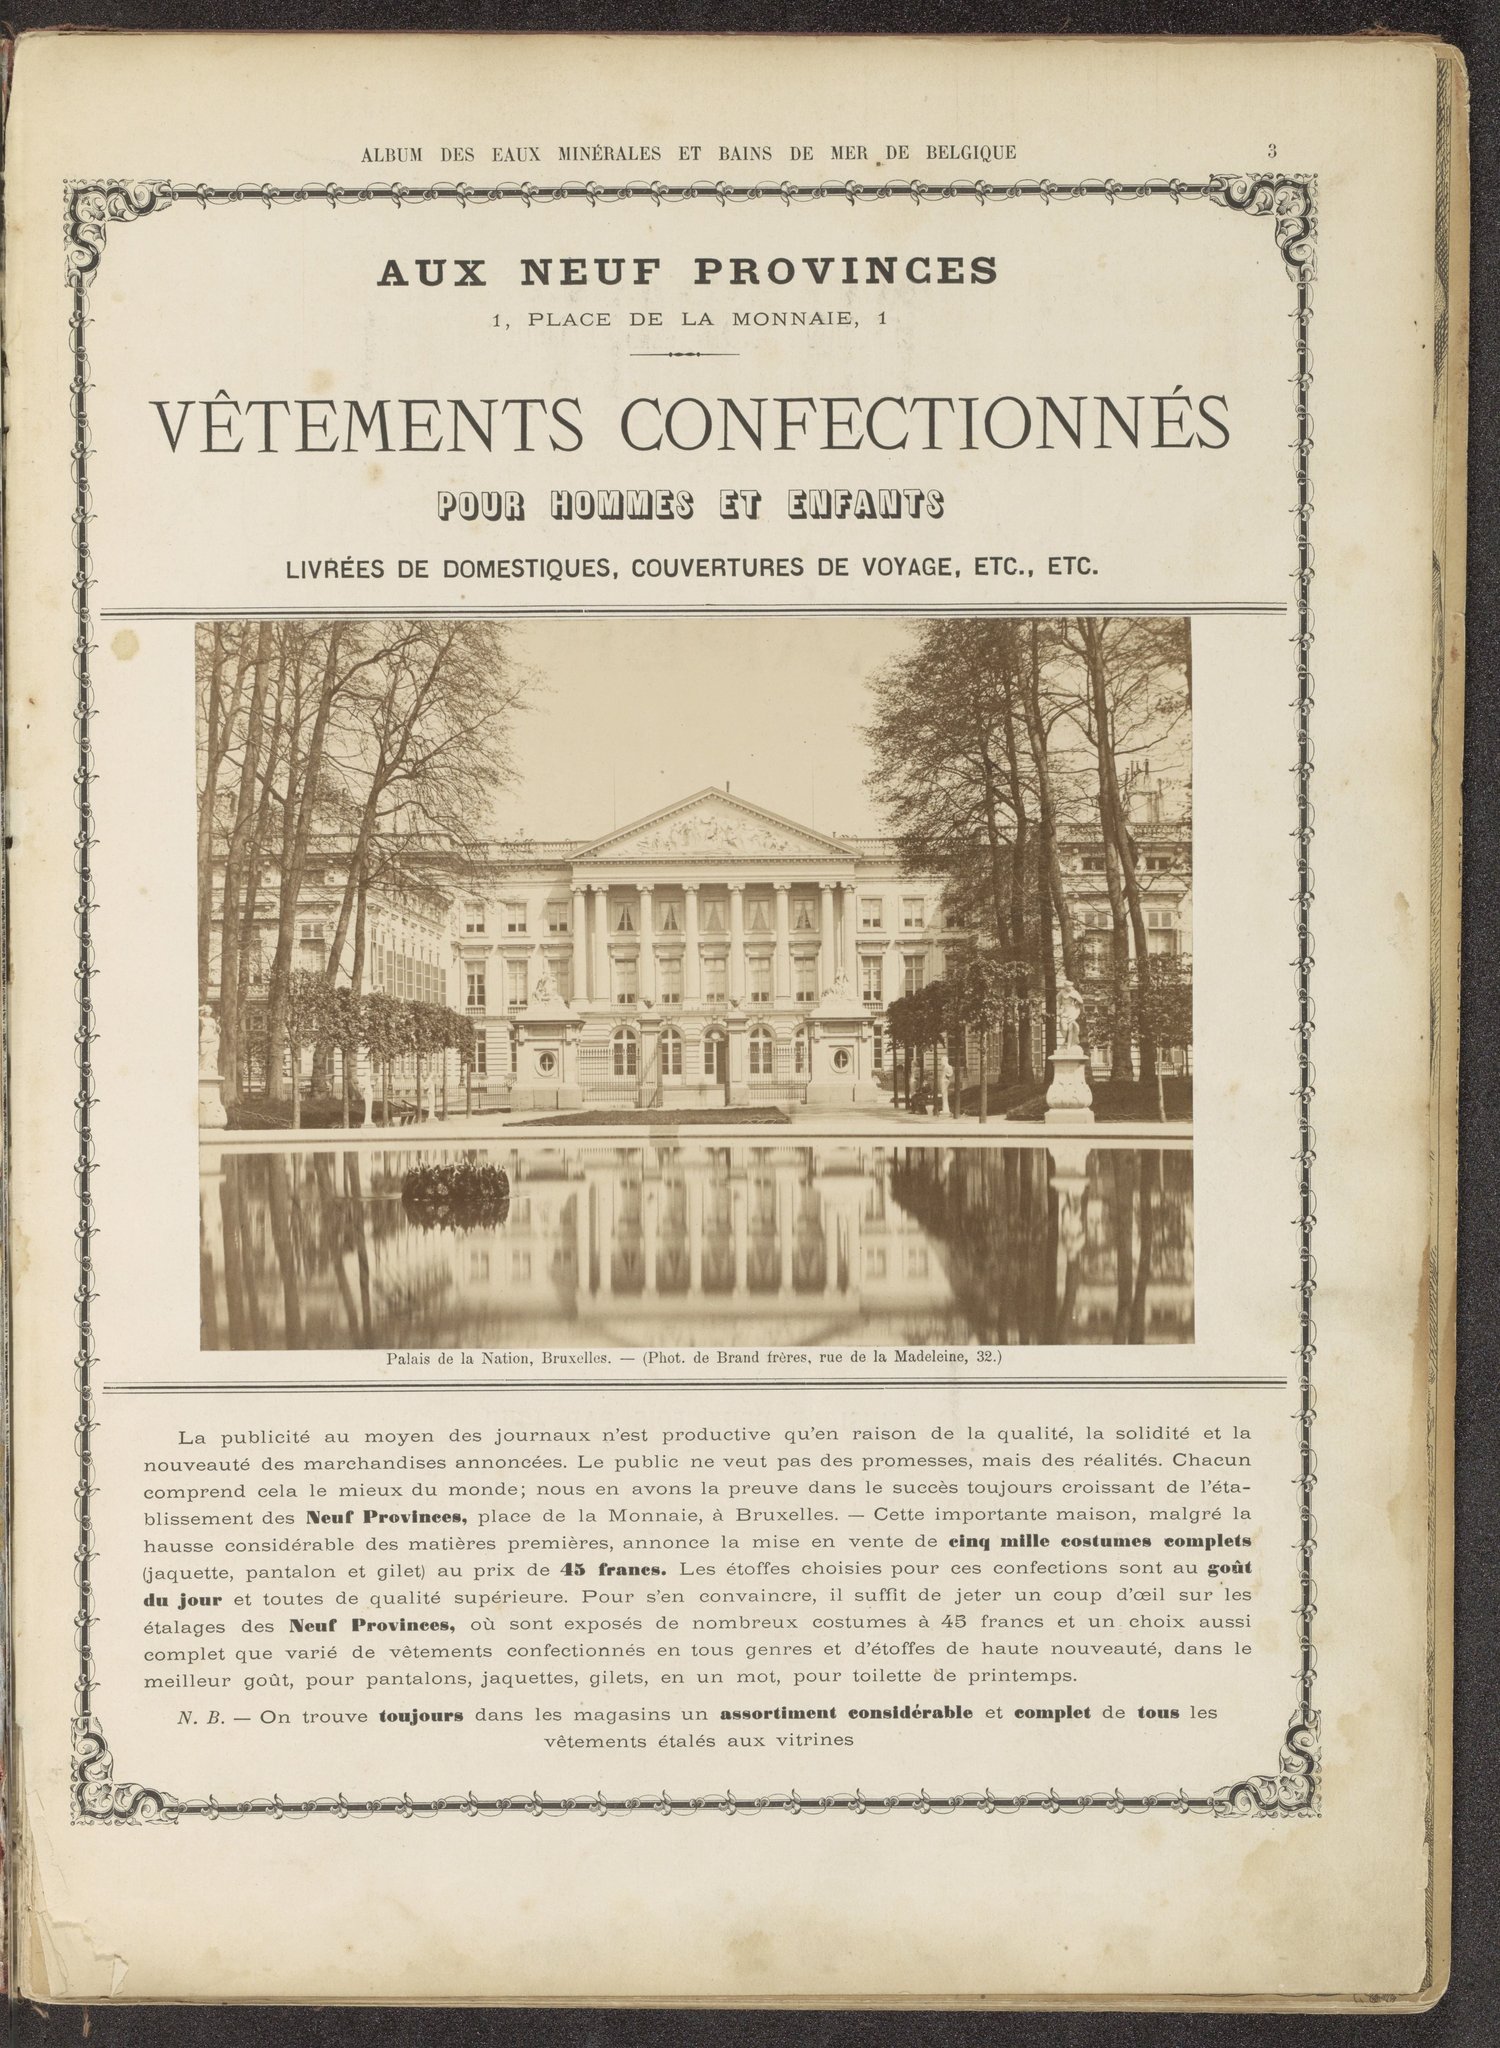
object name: photograph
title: Gezicht op de voorgevel van het Paleis der Natie te Brussel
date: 1862-1872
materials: photographic support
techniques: albumen print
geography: brussels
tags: pond, pool, façade (of house or building), lower house, parliament, chamber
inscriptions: name: ‘(Phot. de Brand frères, rue de la Madeleine, 32.)’